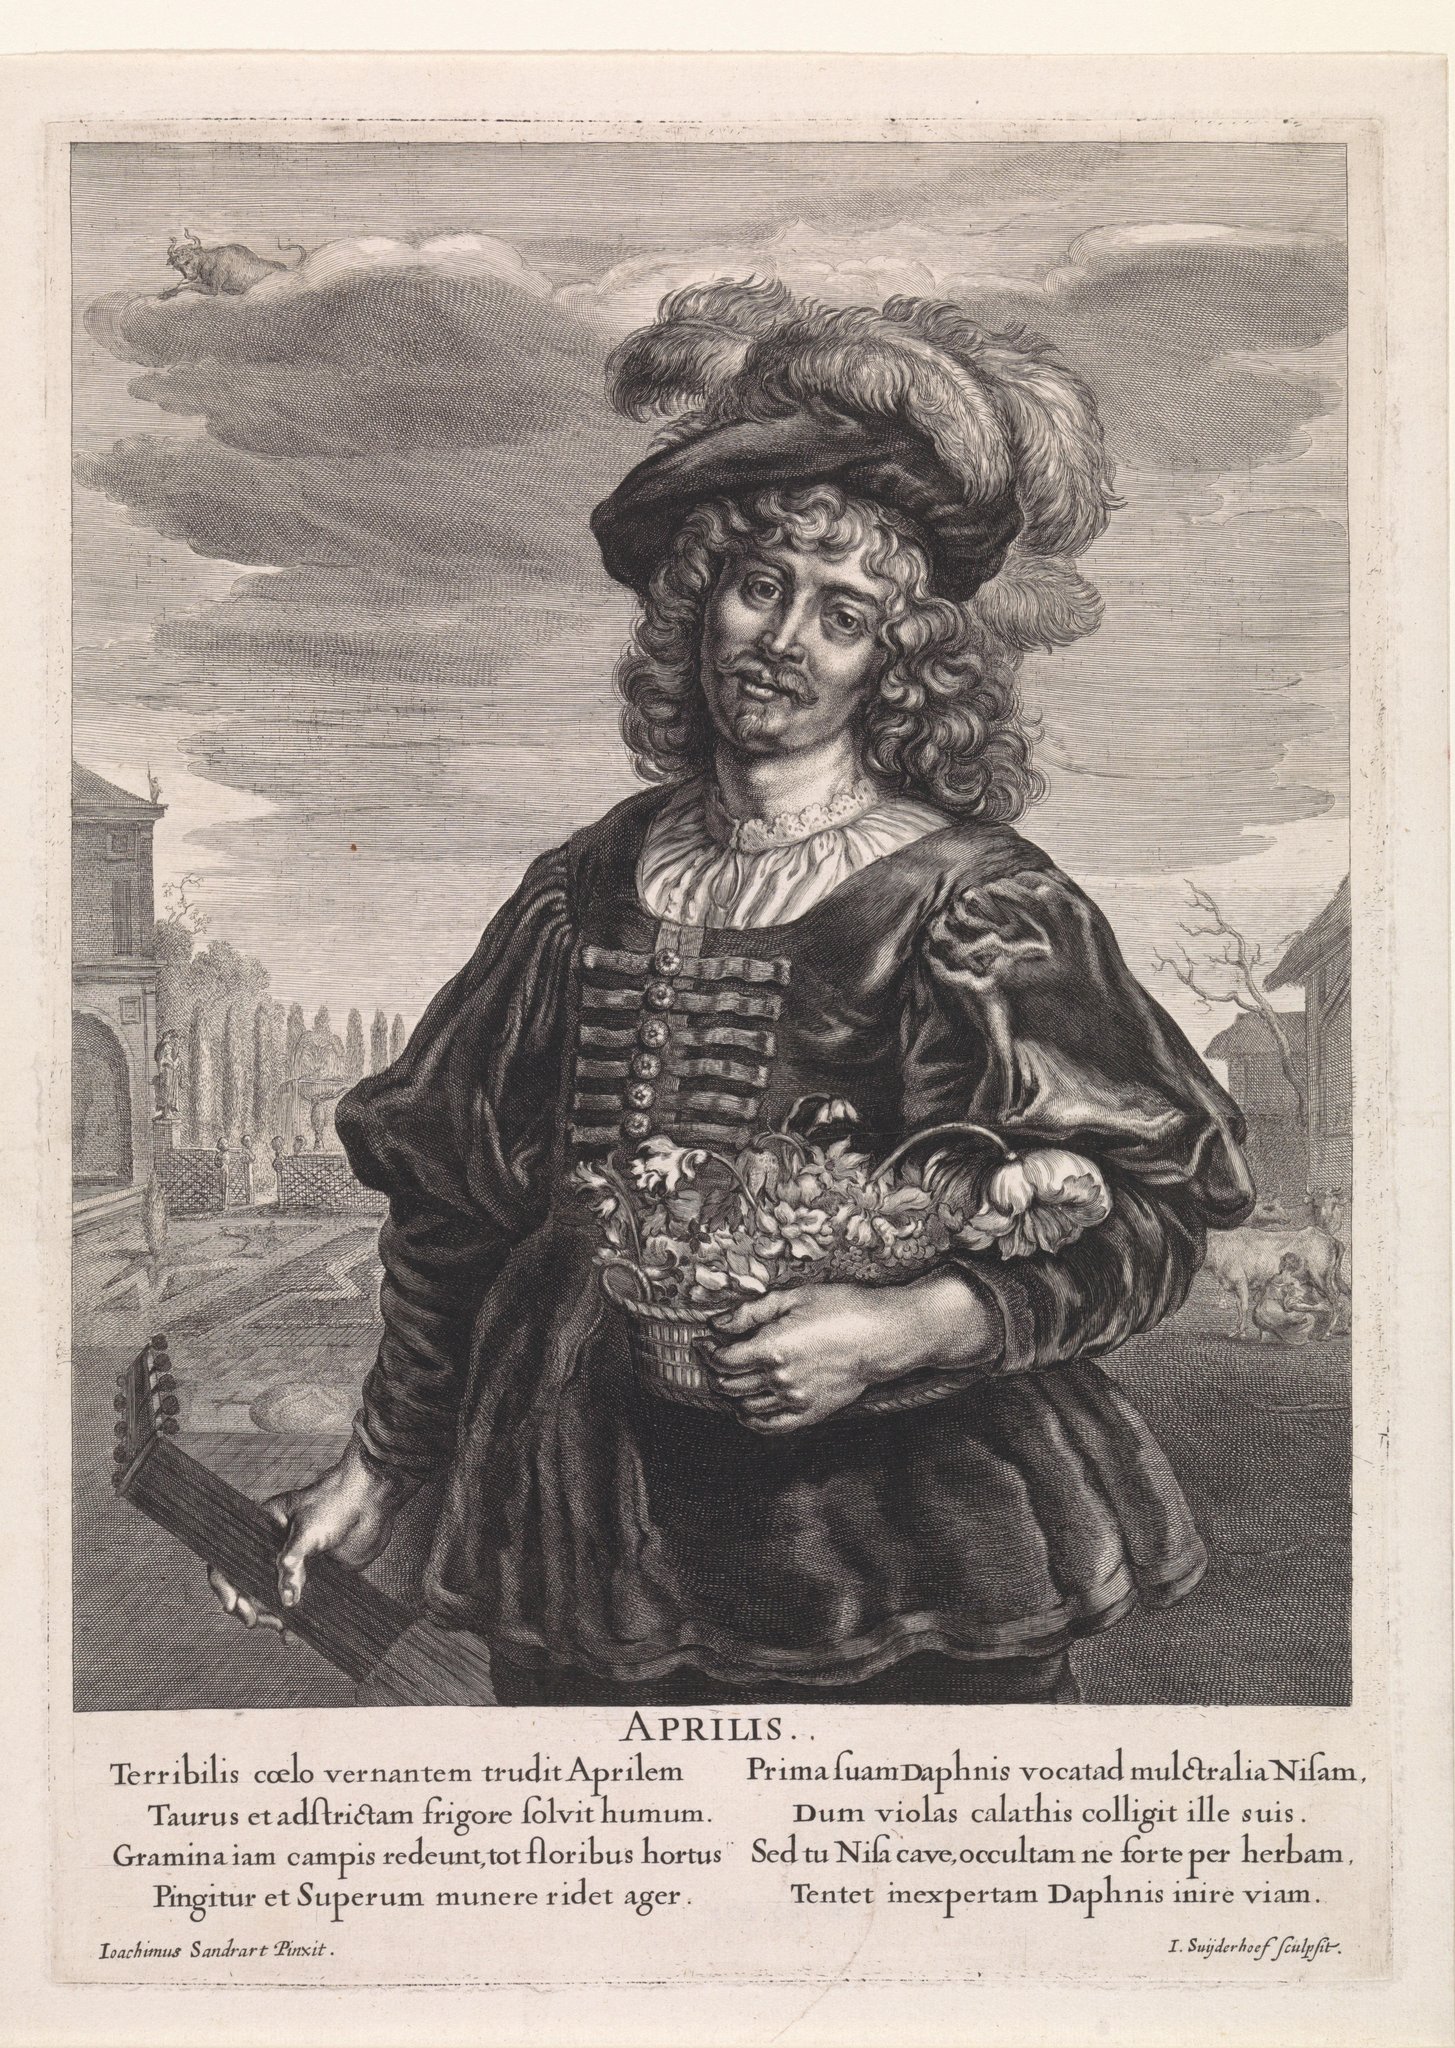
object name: print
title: De twaalf maanden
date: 1645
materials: paper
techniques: engraving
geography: amsterdam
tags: april; 'aprile' (ripa) (+ with signs or personifications of the planets), april ~ other concepts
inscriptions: collector's mark: Lugt 240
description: Joachim van Sandrart gaf de prenten naar zijn schilderijen van de twaalf maanden, de dag en de nacht, zelf uit in 1645. Zij werden vervaardigd door verschillende graveurs: Theodor Matham, Reinier van Persijn, Jonas Suyderhoef, Jeremias Falck, Cornelis van Dalen (II) en Albert Haelwegh.